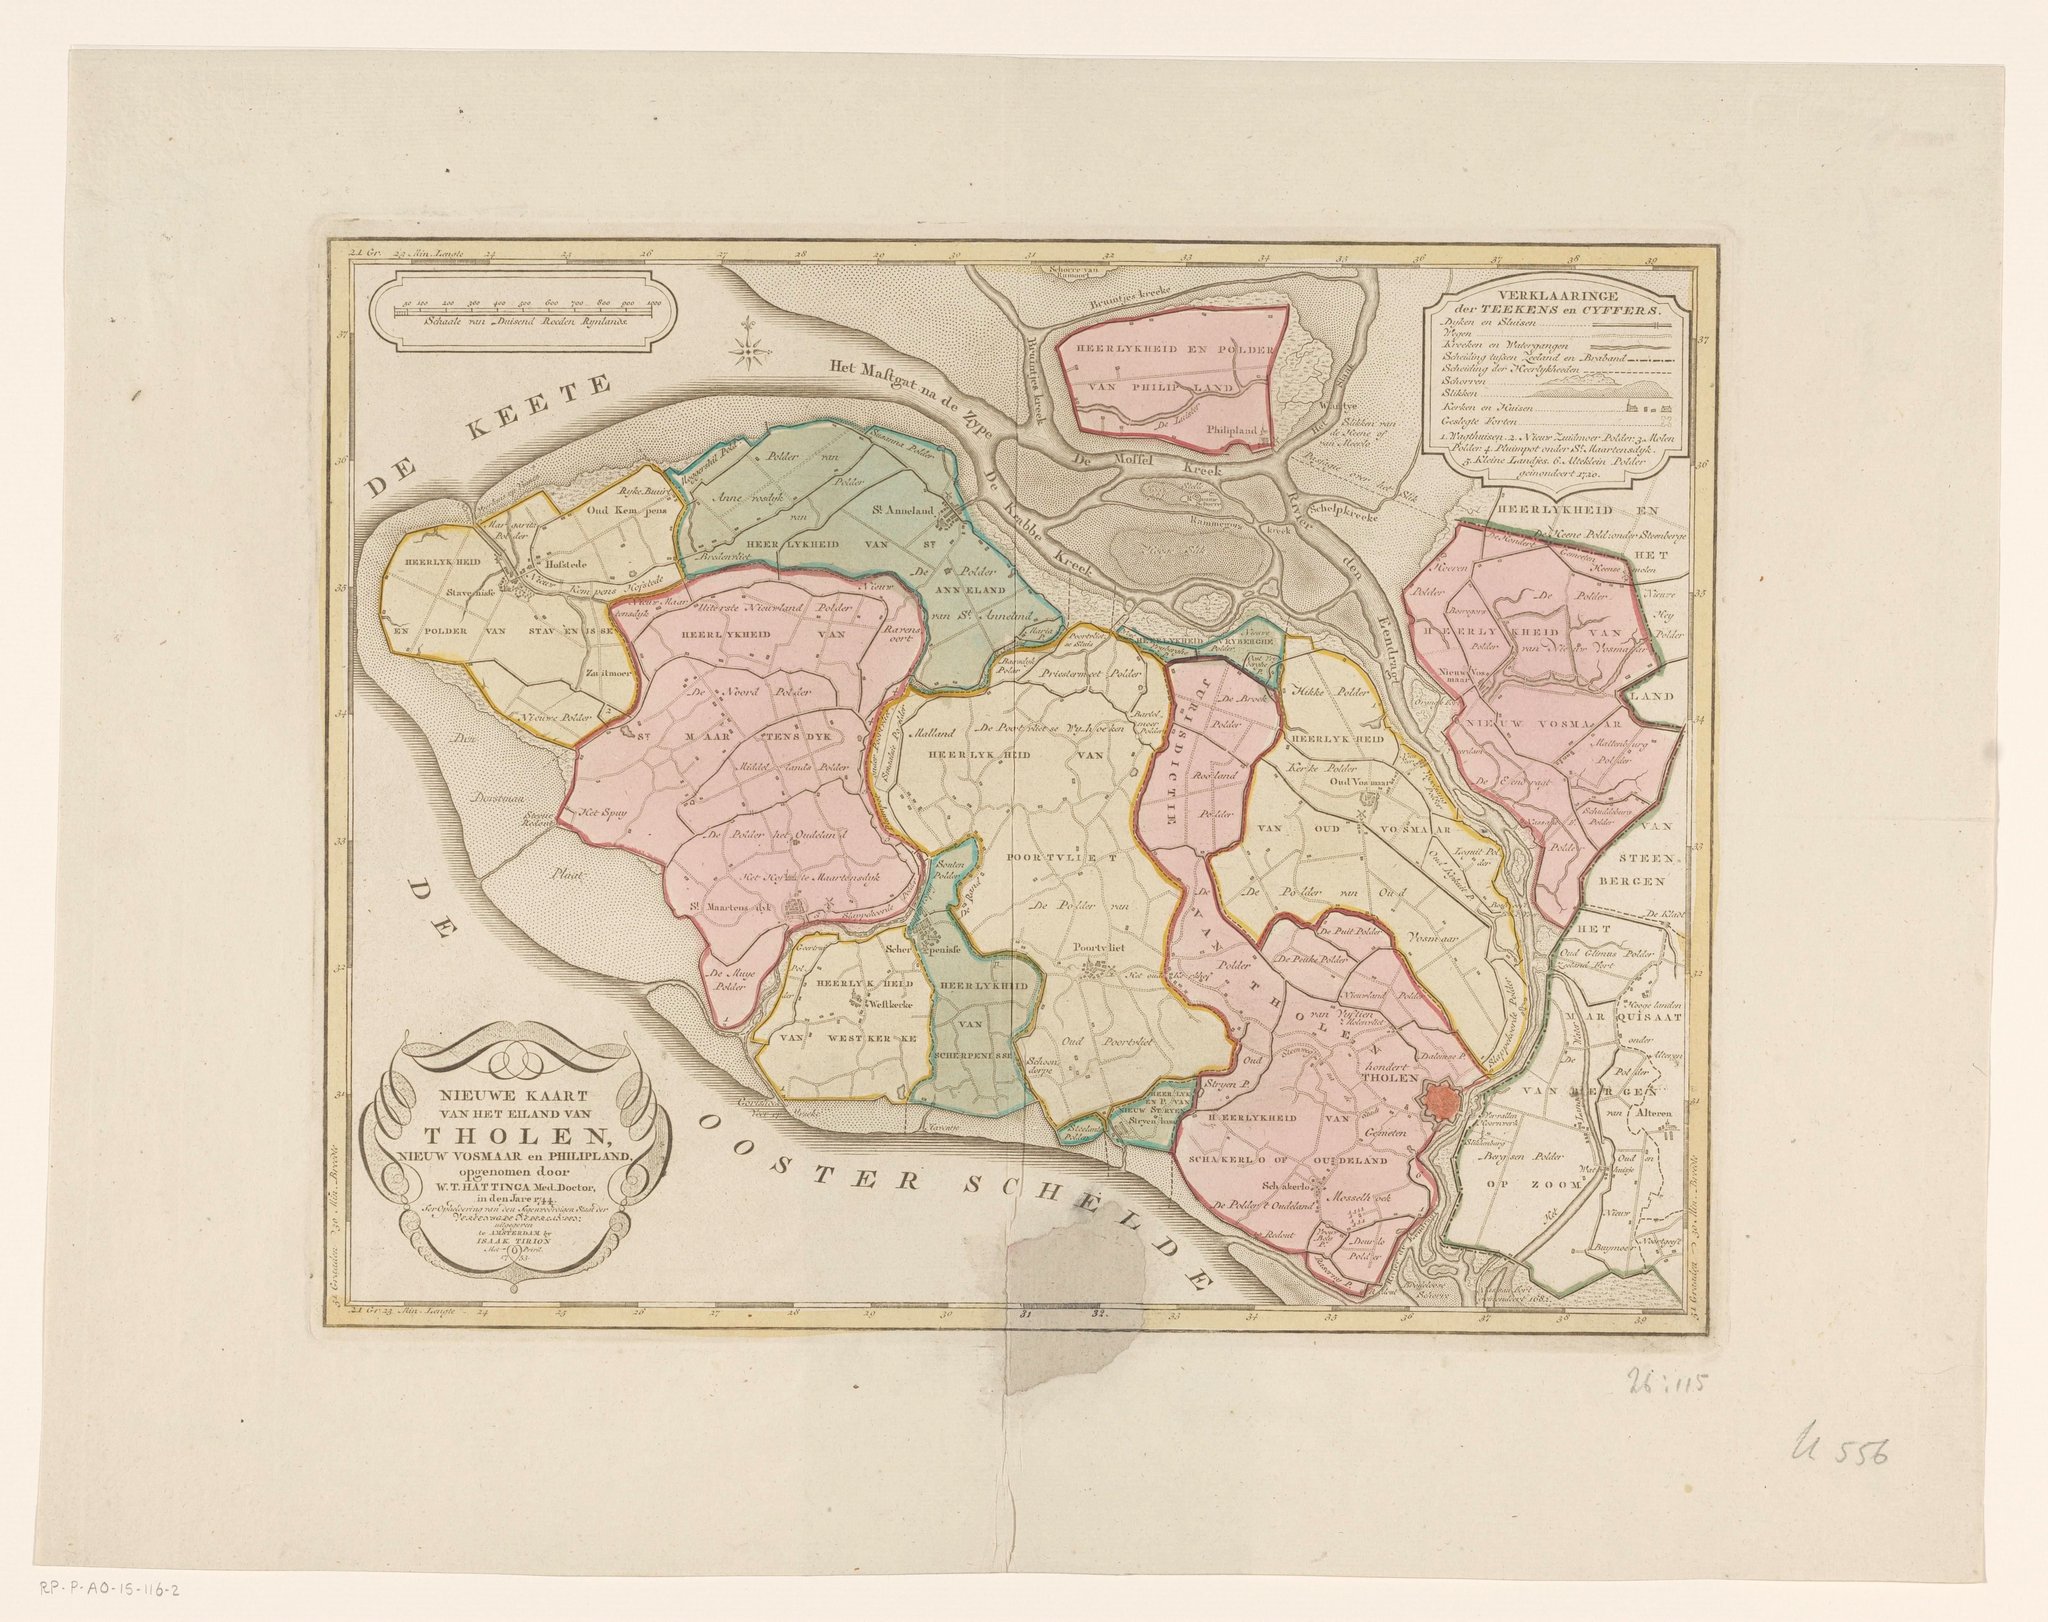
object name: print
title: Kaart van het eiland Tholen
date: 1753-1760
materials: ink, paper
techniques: brush, engraving, etching, pen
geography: amsterdam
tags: maps of separate countries or regions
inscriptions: collector's mark: Lugt 19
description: Linksboven een schaalstok: Schaale van duisend roeden Rynlands. Linksonder de titelcartouche. Rechtsboven een cartouche met de legenda. Gradenverdeling langs de randen.